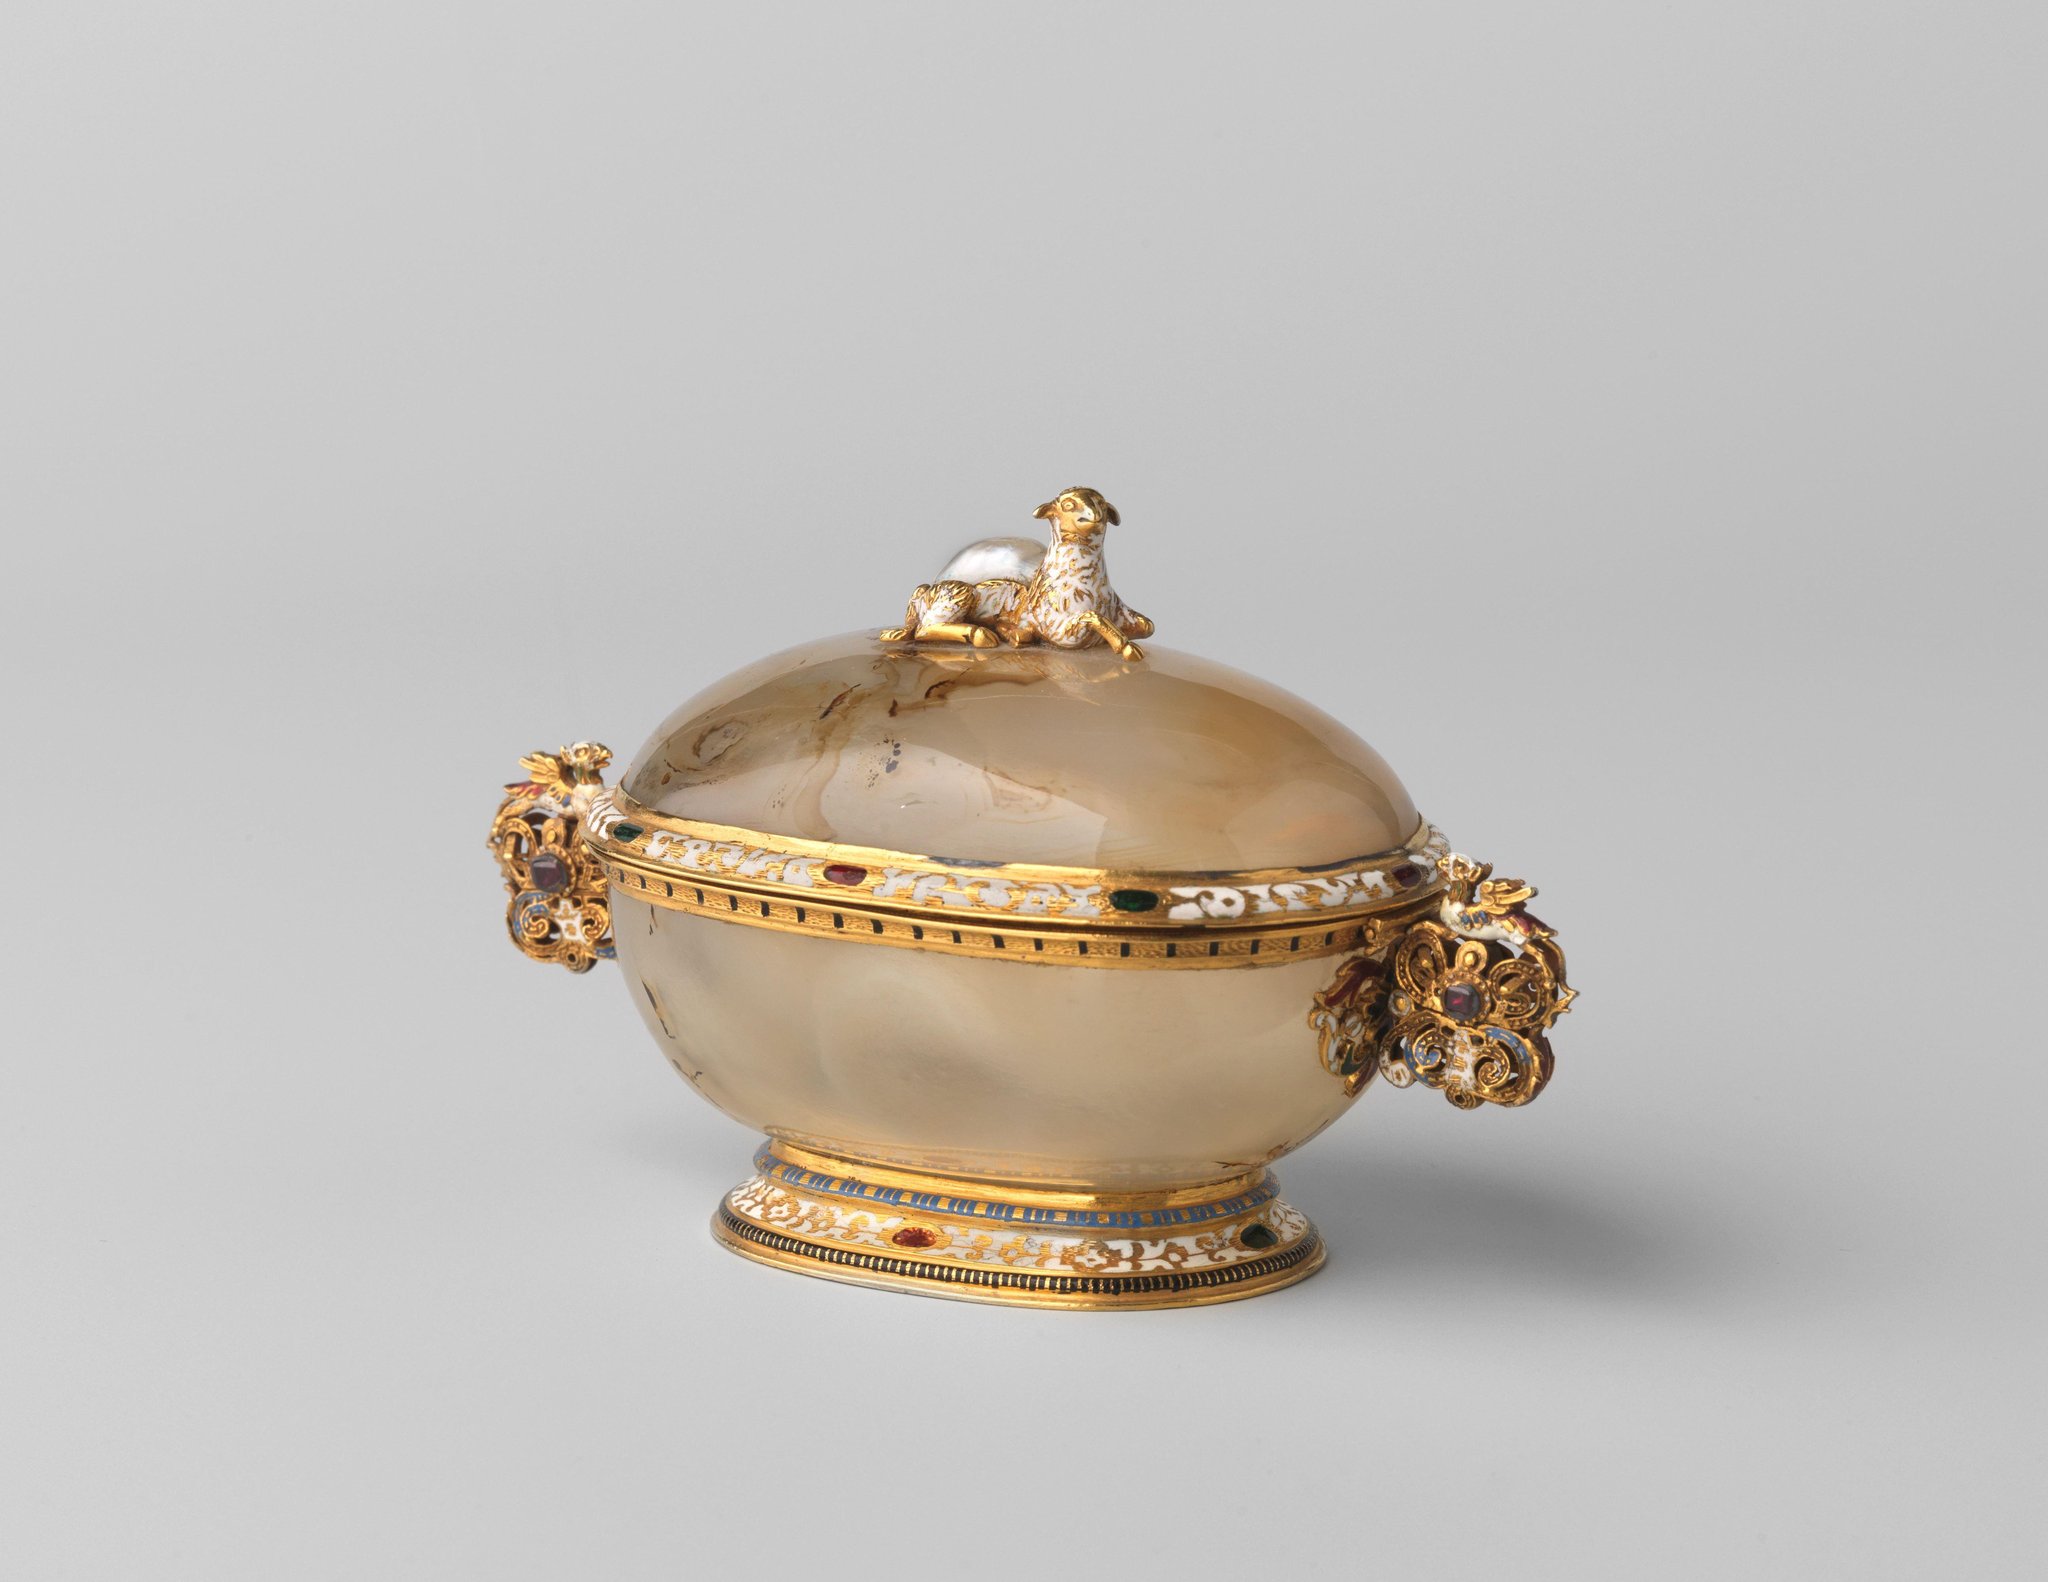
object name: aiguillère, dekschaal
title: Dekschaaltje van doorschijnend agaat, ovaal, gemonteerd met geëmailleerd goud en barokparel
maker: Anonymous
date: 1575-1600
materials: stone, gold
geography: germany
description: Dekschaaltje van doorschijnend agaat, ovaal, gemonteerd met geëmailleerd goud en barokparel. Voet vertoont gouden motieven op witte fond. Twee uit voluten samengestelde geëmailleerd gouden oren, bekroond door een gevleugelde draak. Het montuur is tussen 1911 en 1914 veranderd.